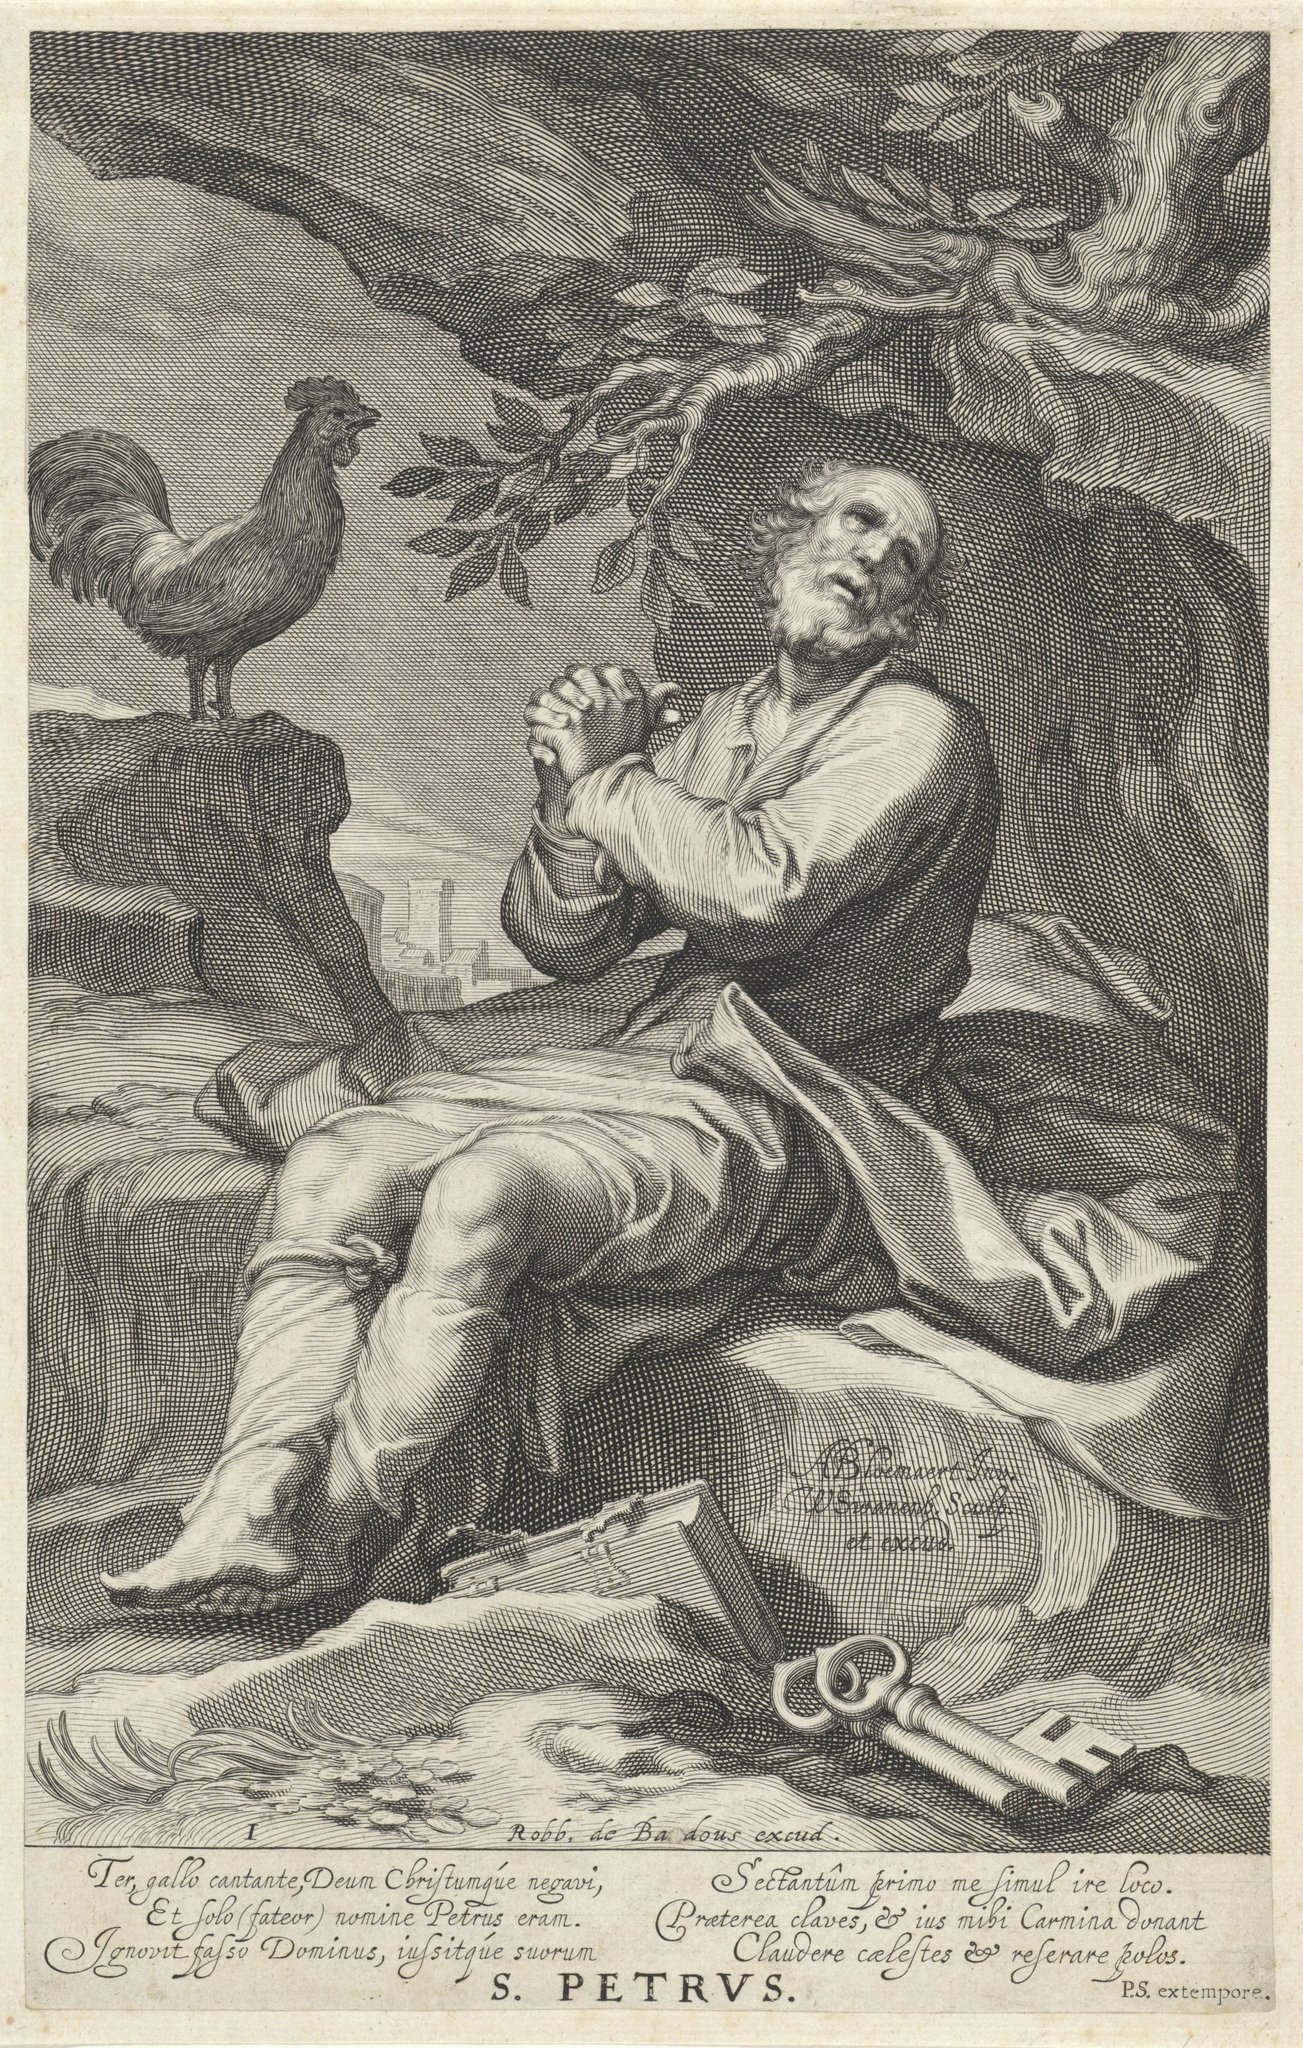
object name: print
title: Zondaars uit het Oude en Nieuwe Testament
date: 1609-1611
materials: paper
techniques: engraving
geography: utrecht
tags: landscapes, the apostle peter, first bishop of rome; possible attributes: book, cock, (upturned) cross, (triple) crozier, fish, key, scroll, ship, tiara - portrait of male saint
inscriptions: collector's mark: Lugt 2228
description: Petrus zit met gevouwen handen op een rots onder een boom. Voor hem liggen twee sleutels en een boek, het evangelie. Schuin achter hem staat een haan, die verwijst naar de verloochening van Christus. In de verte staan enkele gebouwen. Onder de voorstelling bevindt zich een zesregelige, Latijnse tekst over de verloochening en een passage over de sleutels.